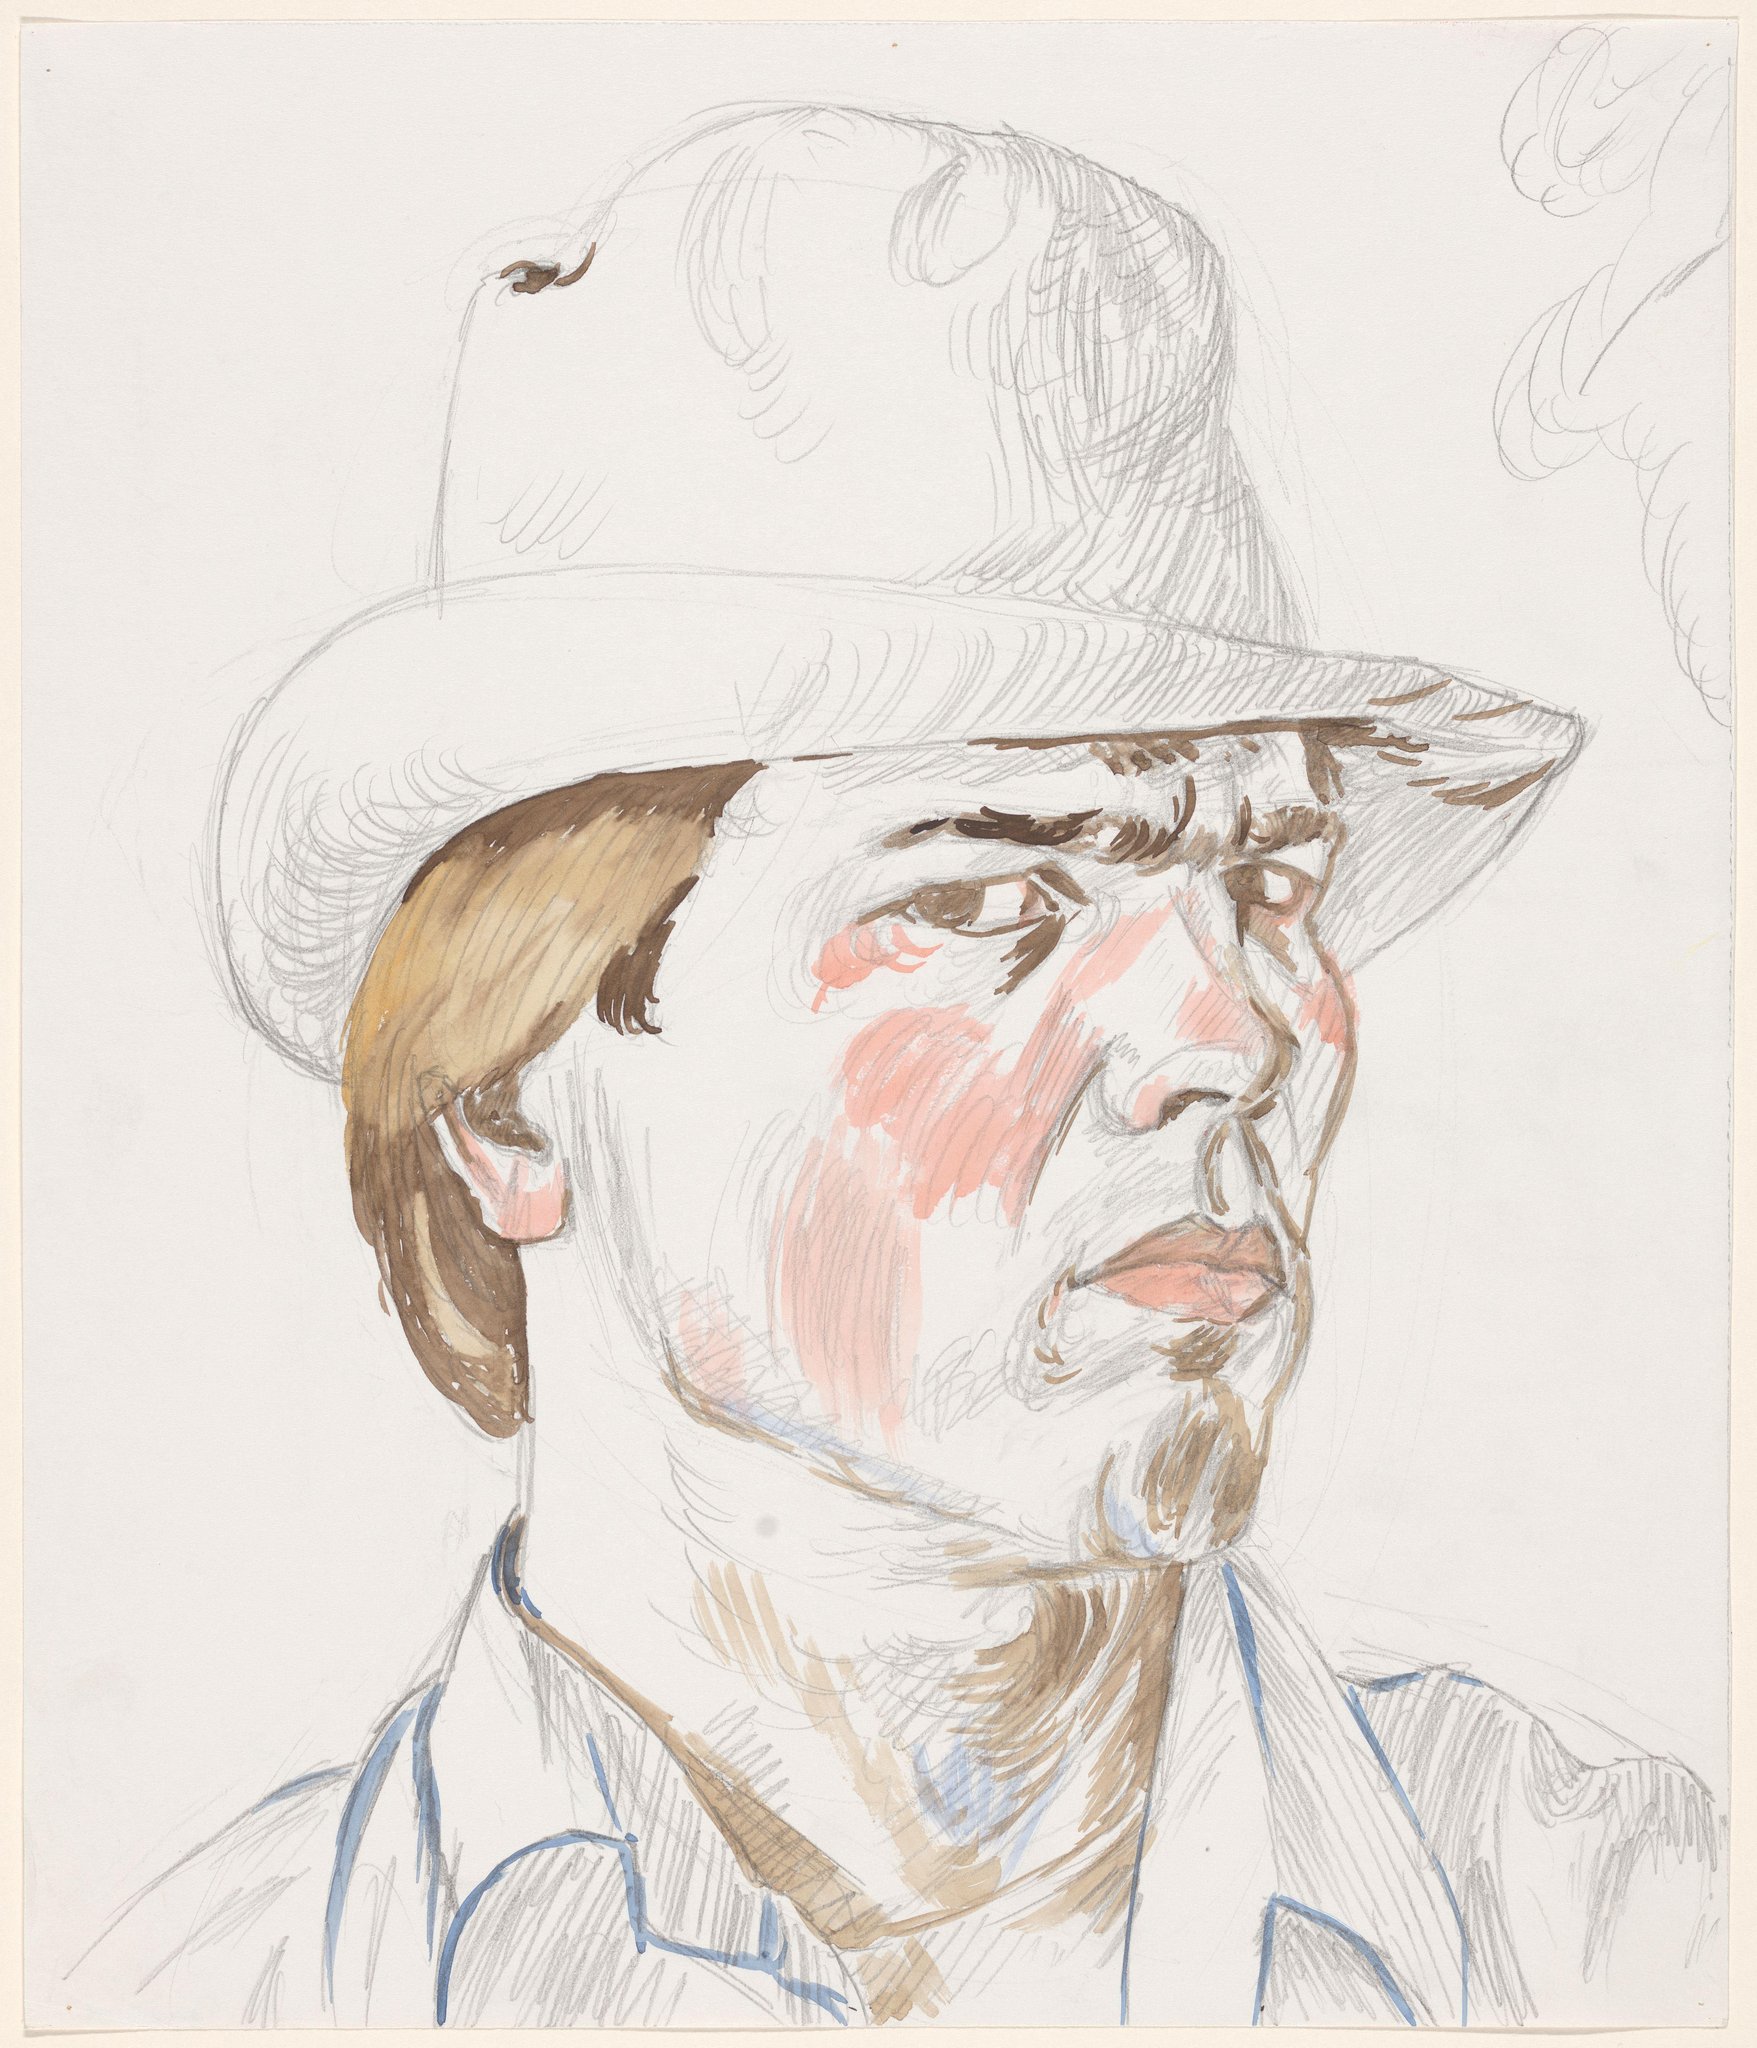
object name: drawing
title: Zelfportret 1988 nr. 6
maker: philip akkerman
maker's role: draughtsman, painter, sculptor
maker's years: 1957-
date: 1988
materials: paper, pencil, watercolor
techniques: brush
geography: netherlands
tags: draughtsman, philip akkerman, head-gear, historical persons, portrait, self-portrait of painter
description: ¾ En face weergegeven jeugdig zelfportret met kort haar, overhemd en hoed.